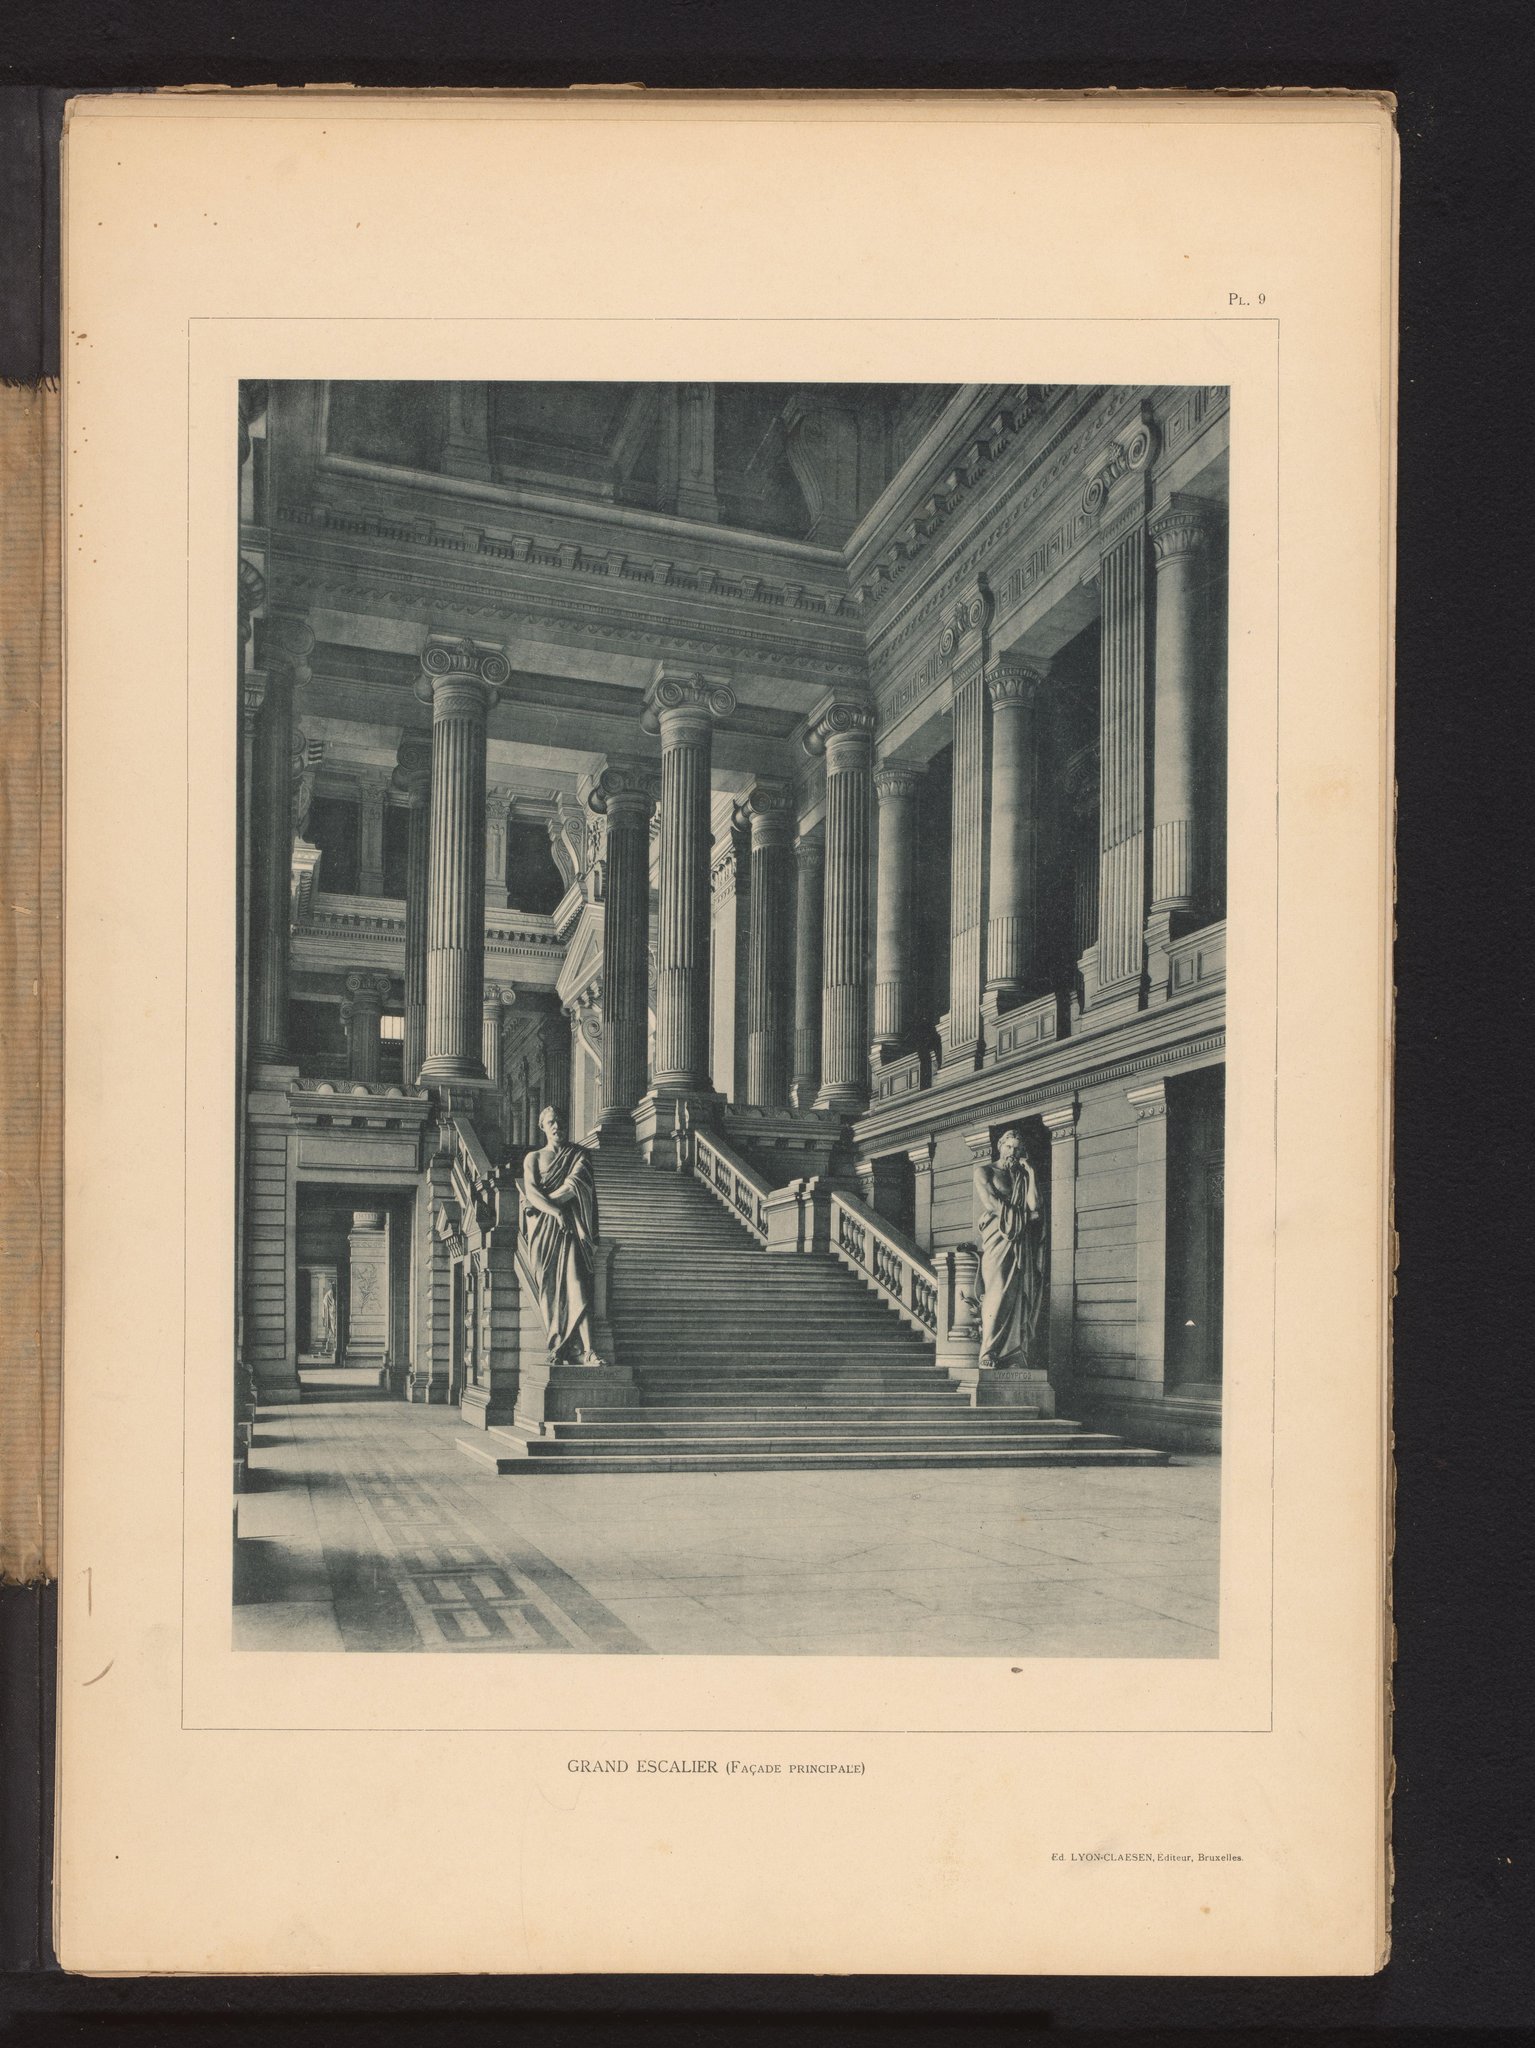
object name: photomechanical print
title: Gezicht op de grote trap aan de voorzijde van het Paleis van Justitie in Brussel, België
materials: paper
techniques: photograph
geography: brussels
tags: court building, staircase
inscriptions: number: ‘PL. 9’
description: Deze prent maakt deel uit van een omslag met 30 prenten op 28 bladen en een titelblad.